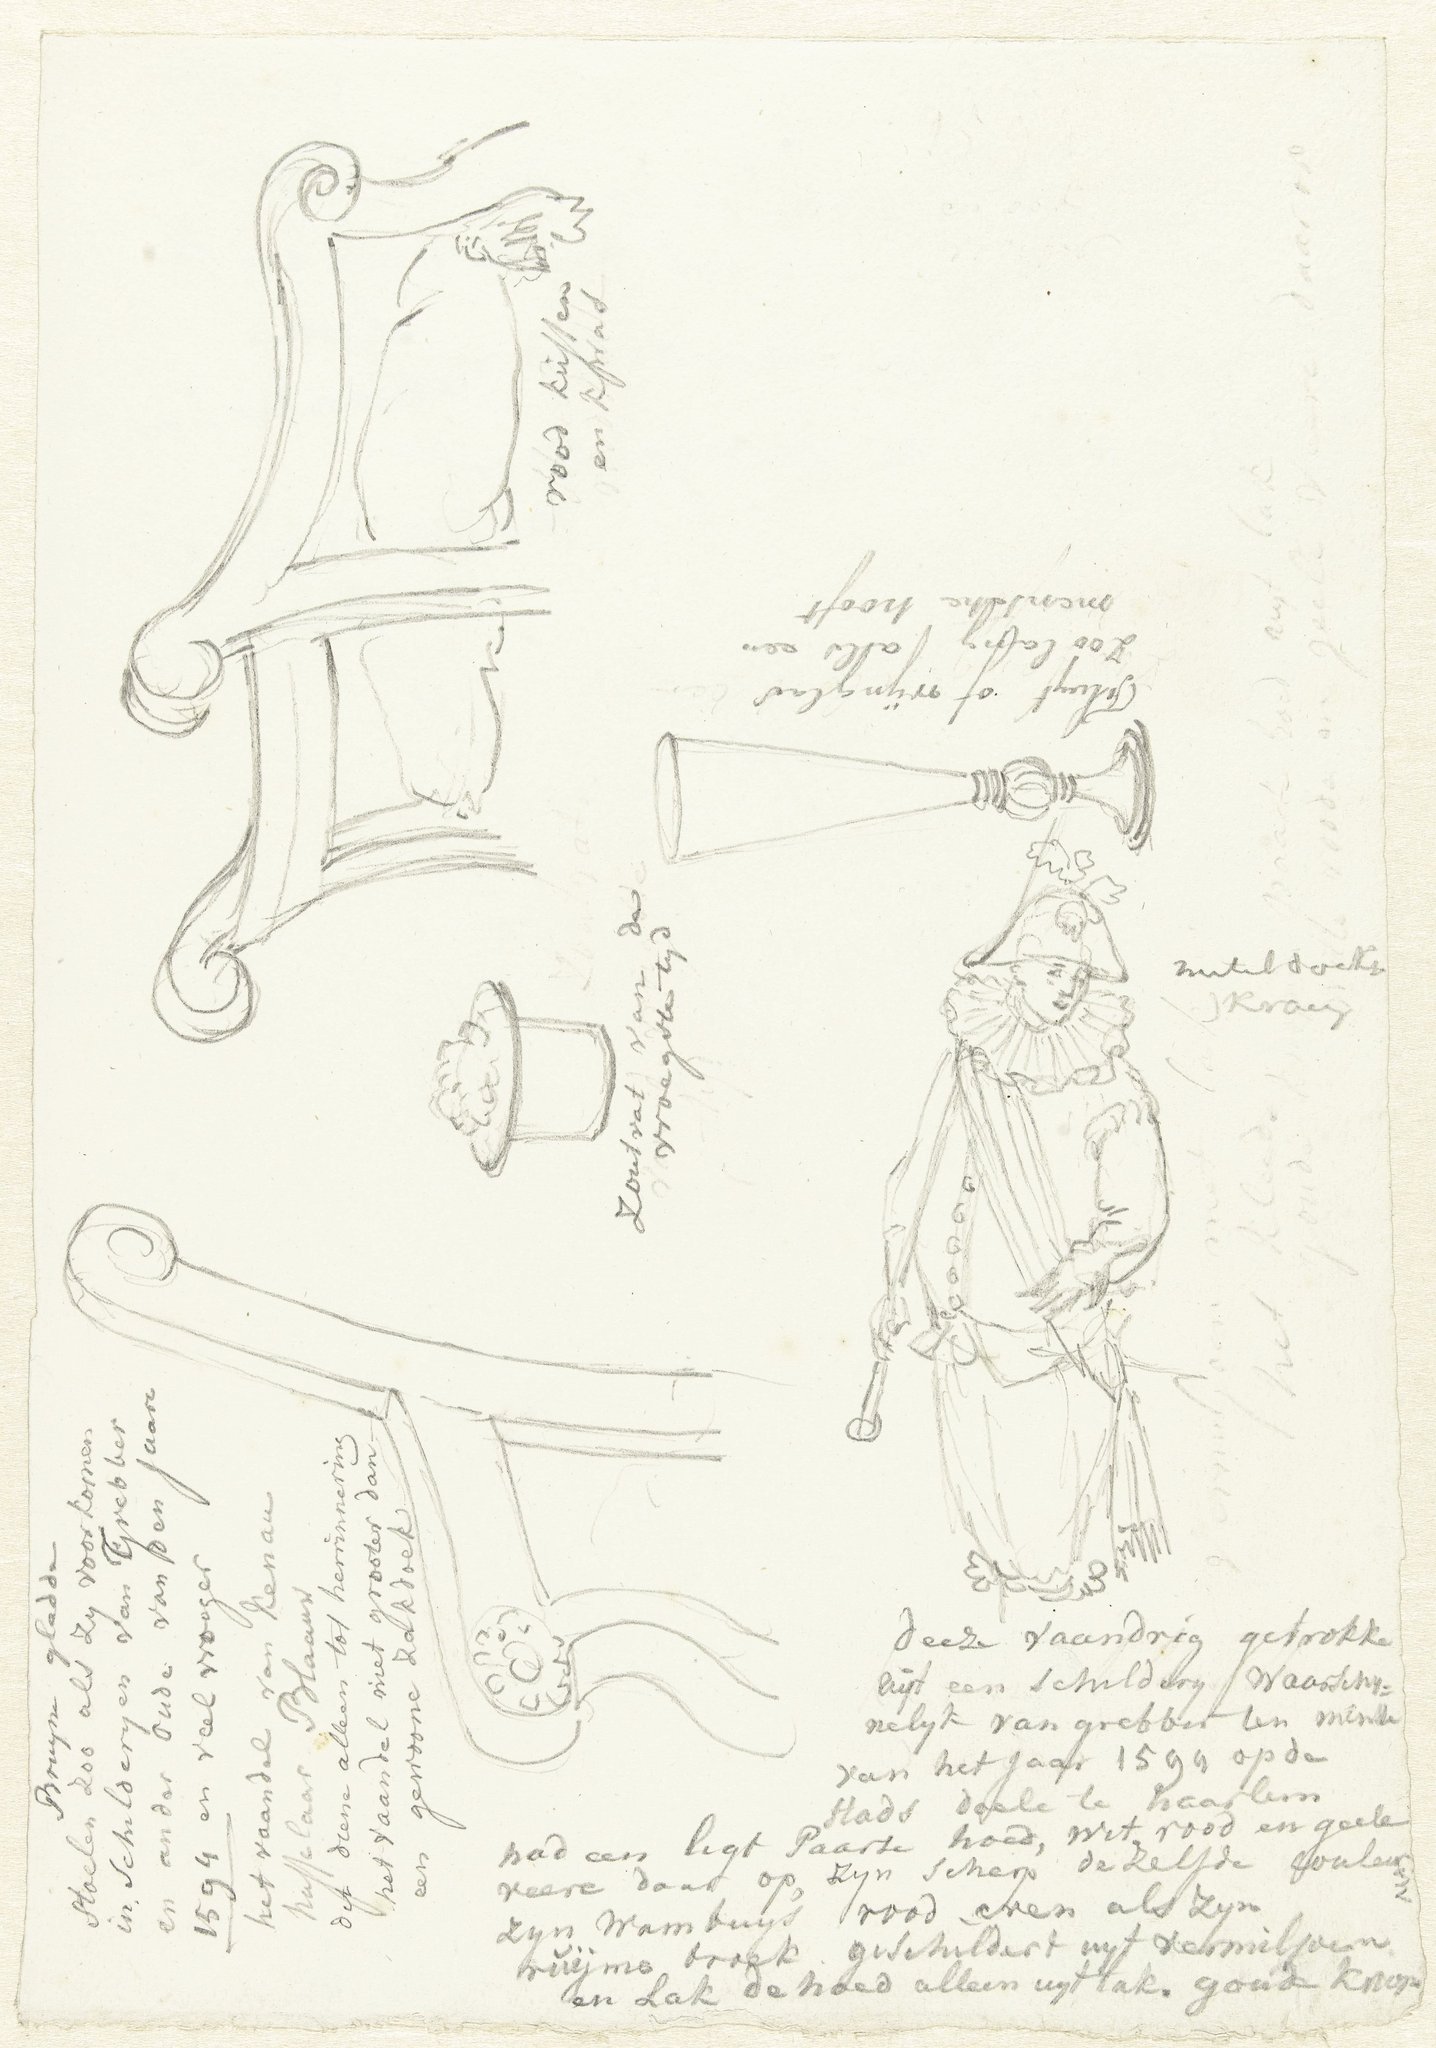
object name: drawing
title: Vaandrig, delen van een stoel, een zoutvat en een glas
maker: pieter bartholomeusz. barbiers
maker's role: draughtsman, print maker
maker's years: 1772-1837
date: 1782-1837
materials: graphite, paper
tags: picture, painting, land forces (+ citizen soldiery, civil guard, citizen militia)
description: Vaandrig, delen van een stoel, een zoutvat en een glas, naar een schilderij te Haarlem.